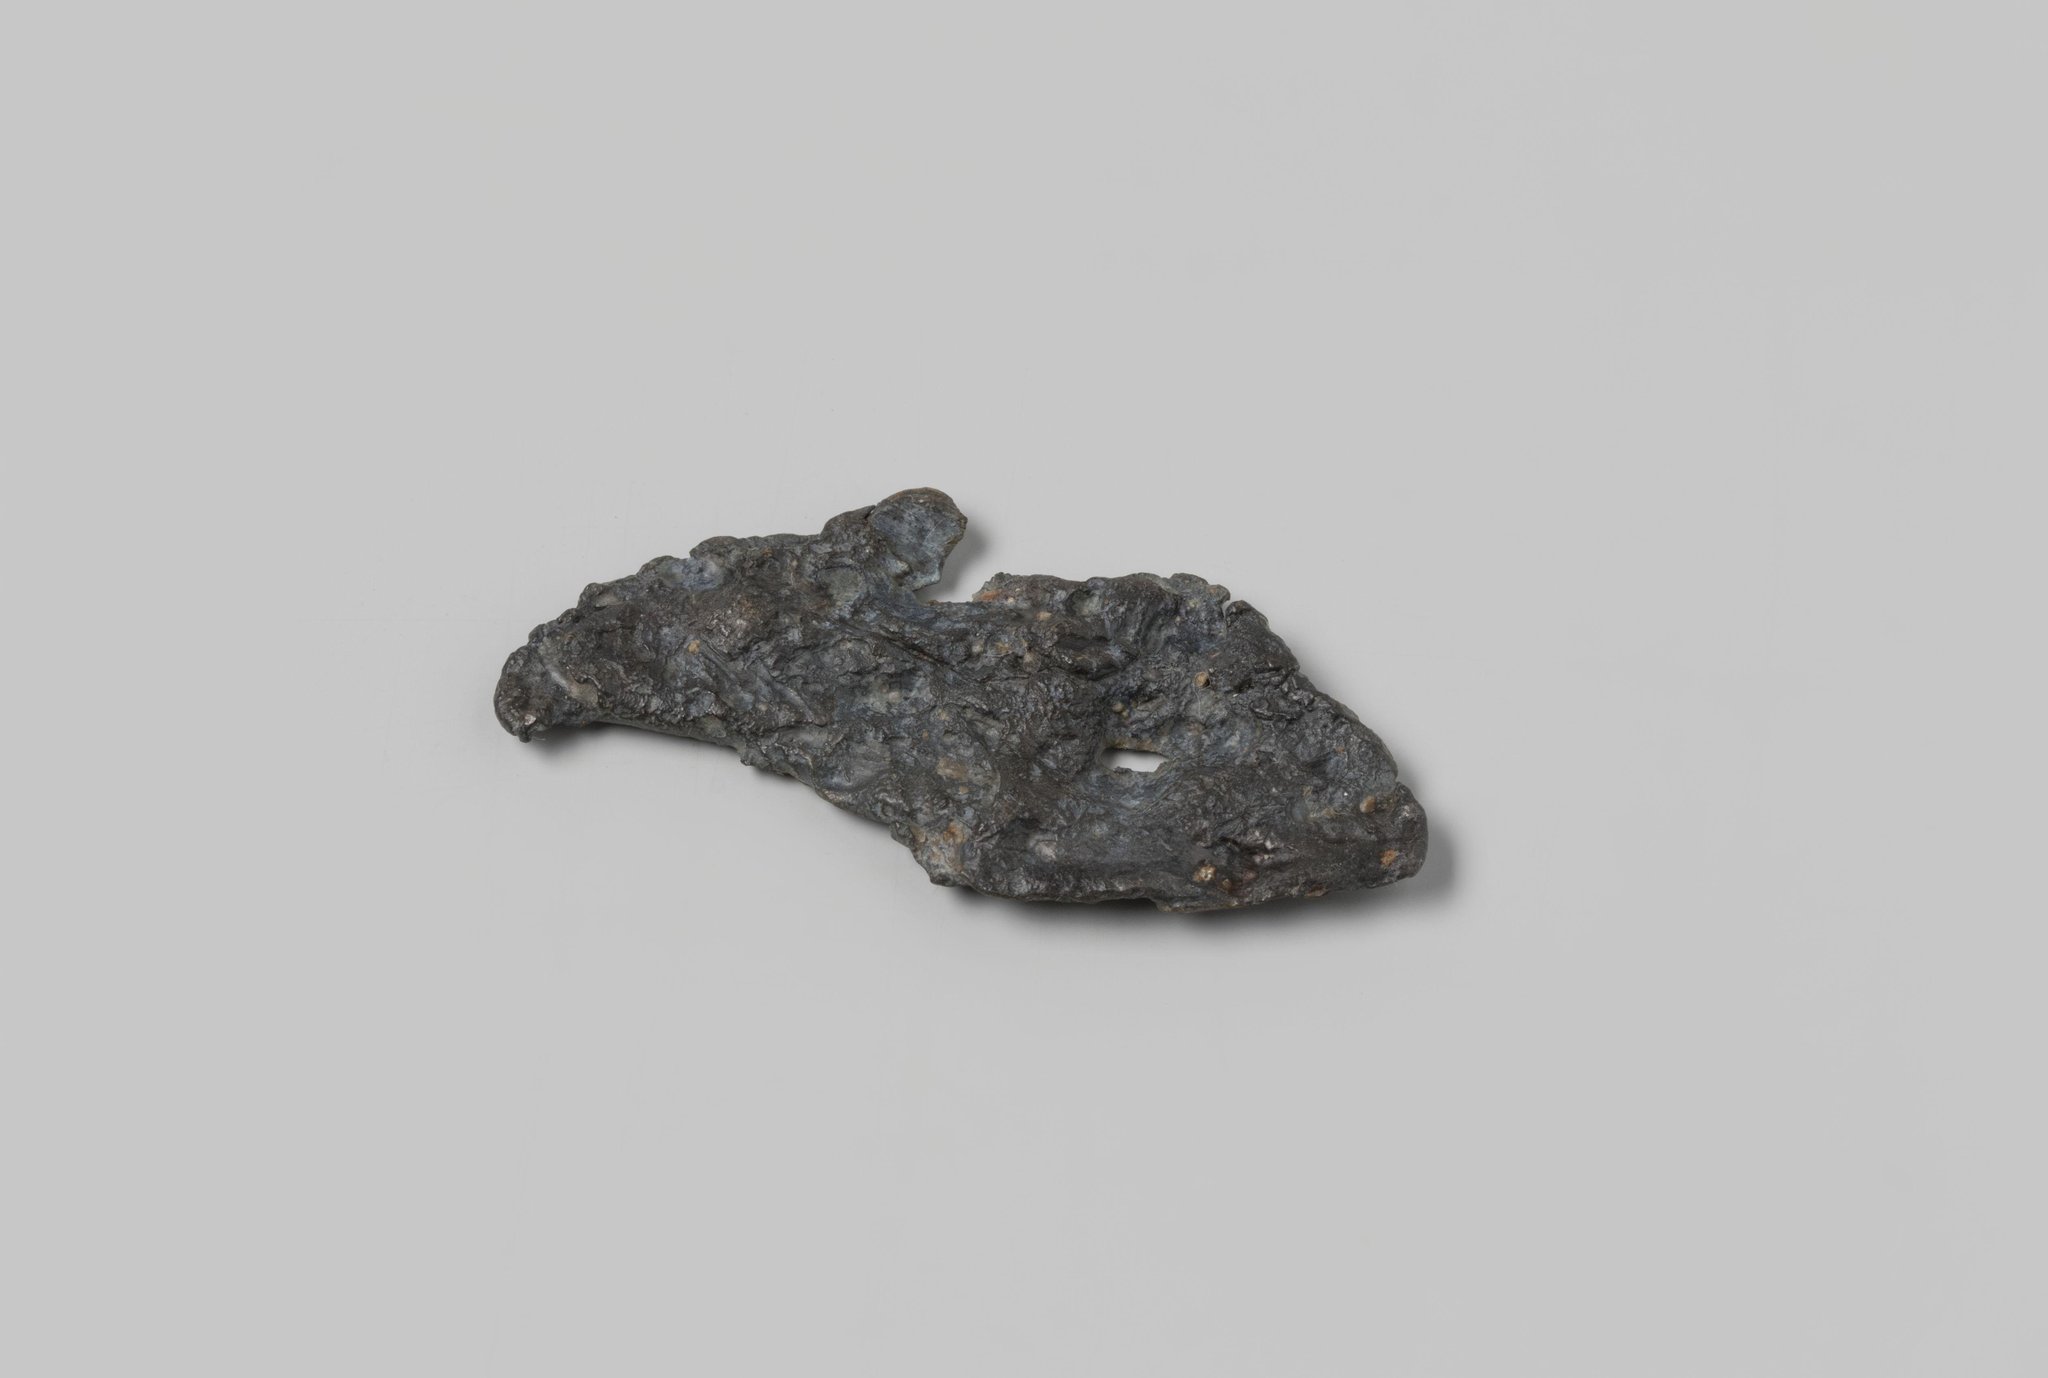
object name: fragment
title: Fragment lood uit het wrak van de Oost-Indiëvaarder Hollandia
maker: Anonymous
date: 1700-1743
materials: lead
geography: netherlands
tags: verenigde oostindische compagnie, hollandia (schip), annet